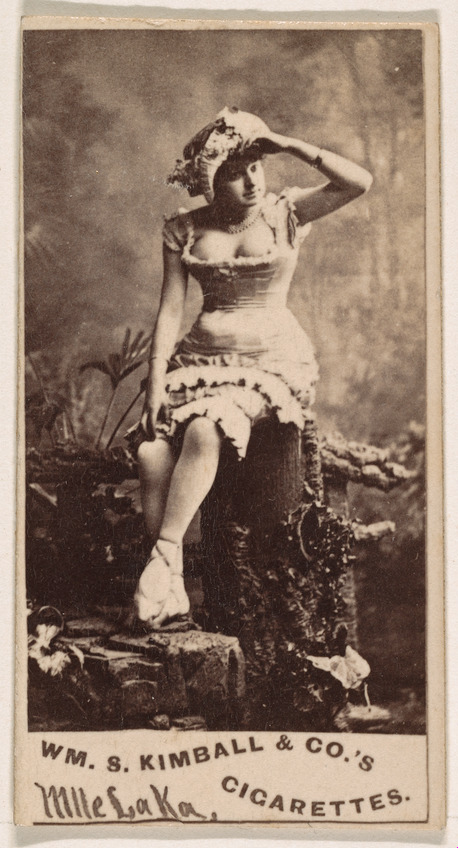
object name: photograph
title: Mlle. Laka, from the Actresses series (N203) issued by Wm. S. Kimball & Co.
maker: william s. kimball & company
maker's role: publisher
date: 1889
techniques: color lithograph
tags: portraits,women,actresses